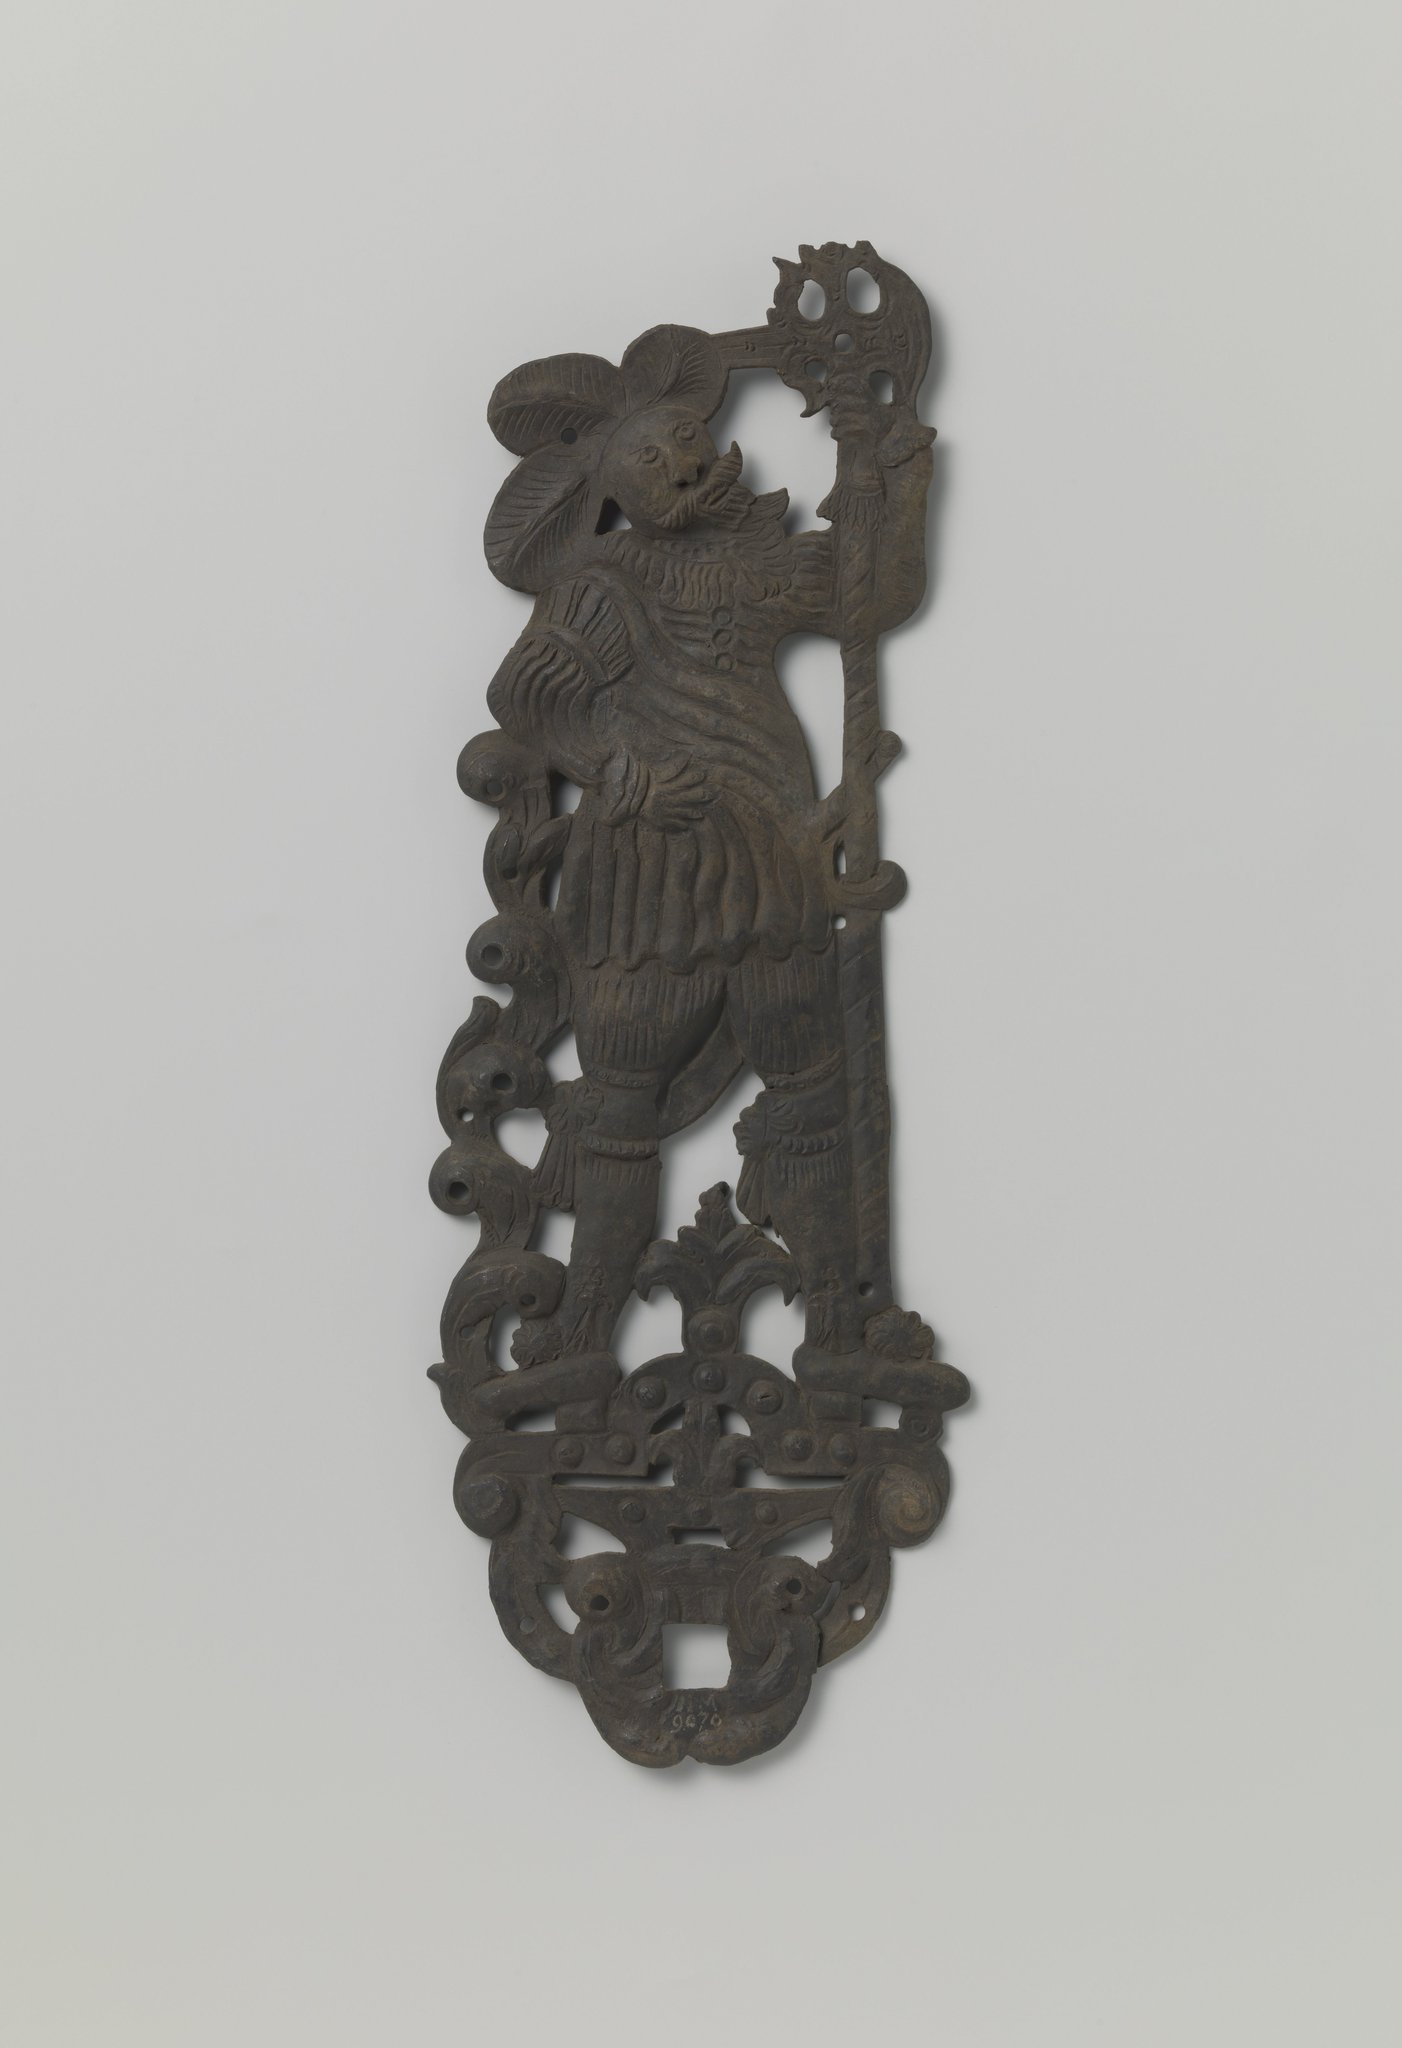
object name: plate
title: Plaat in de vorm van een krijger met hellebaard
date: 1400-1950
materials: iron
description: De plaat bestaat uit een krijgknecht op voetstuk met hellebaard in de linker hand, en hoort bij een deurklopper (BK-NM-9070-2).